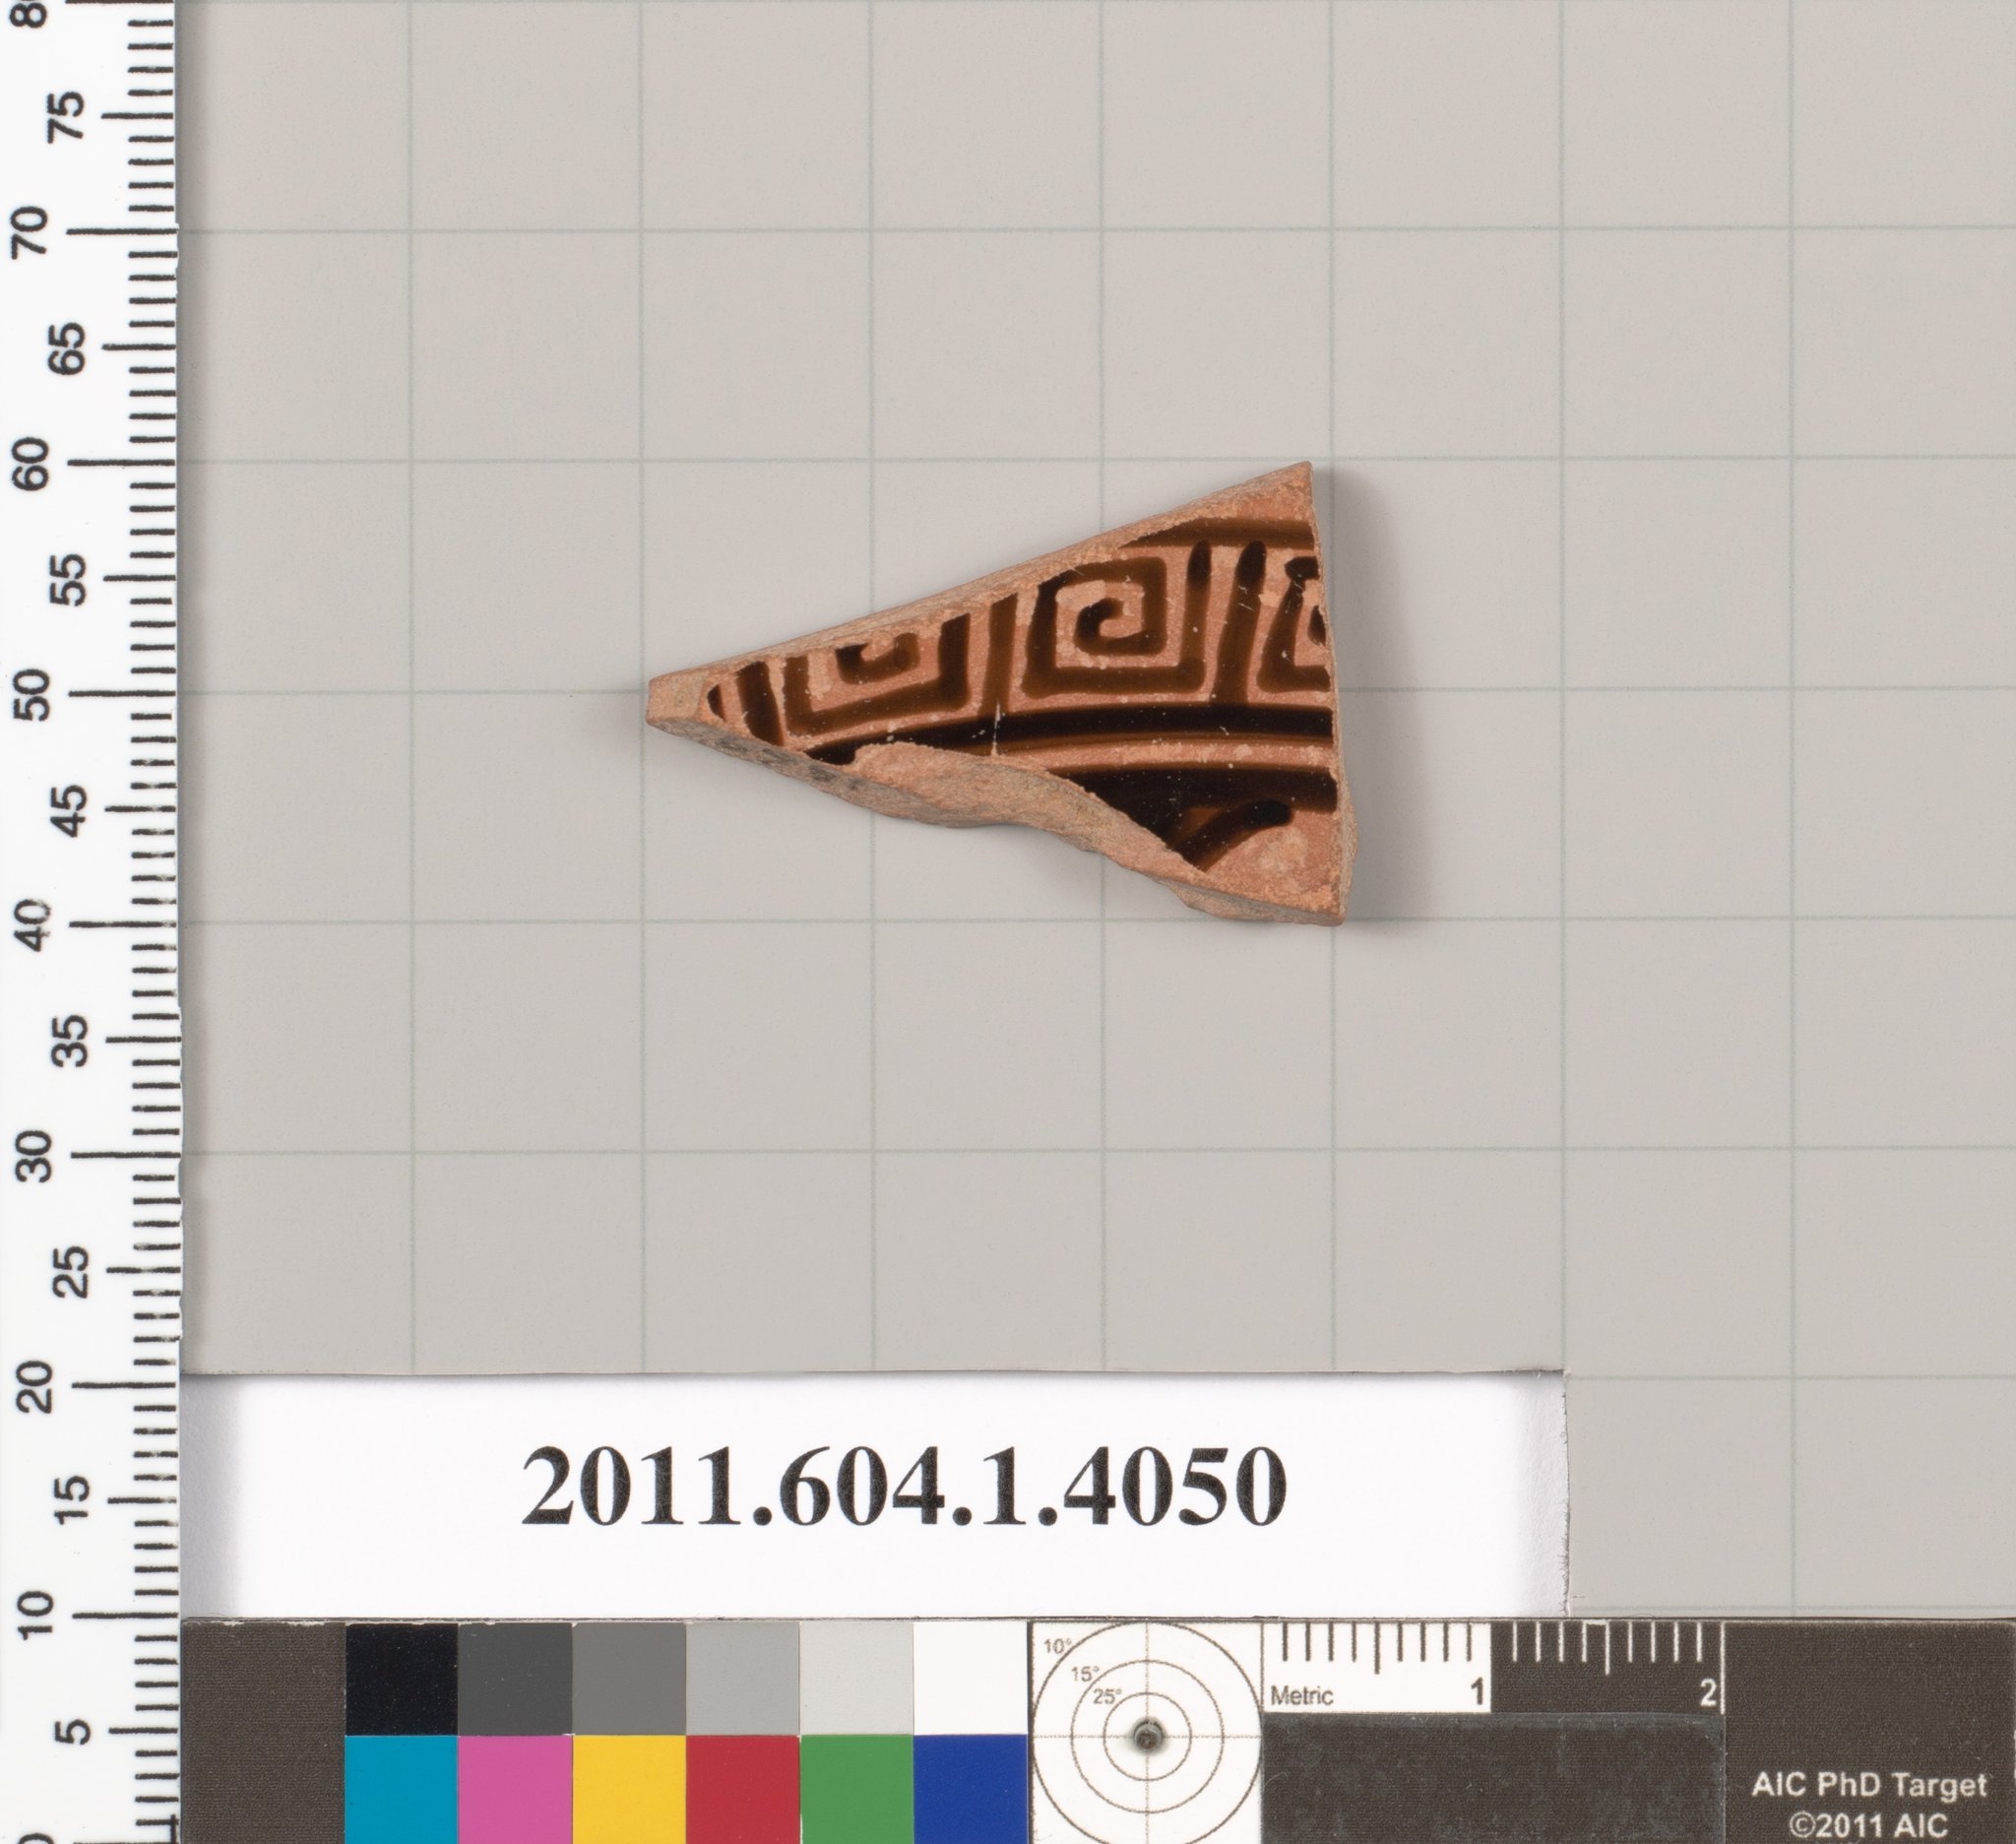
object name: kylix fragment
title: Terracotta fragment of a kylix (drinking cup)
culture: greek, attic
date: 500-480 BCE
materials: terracotta